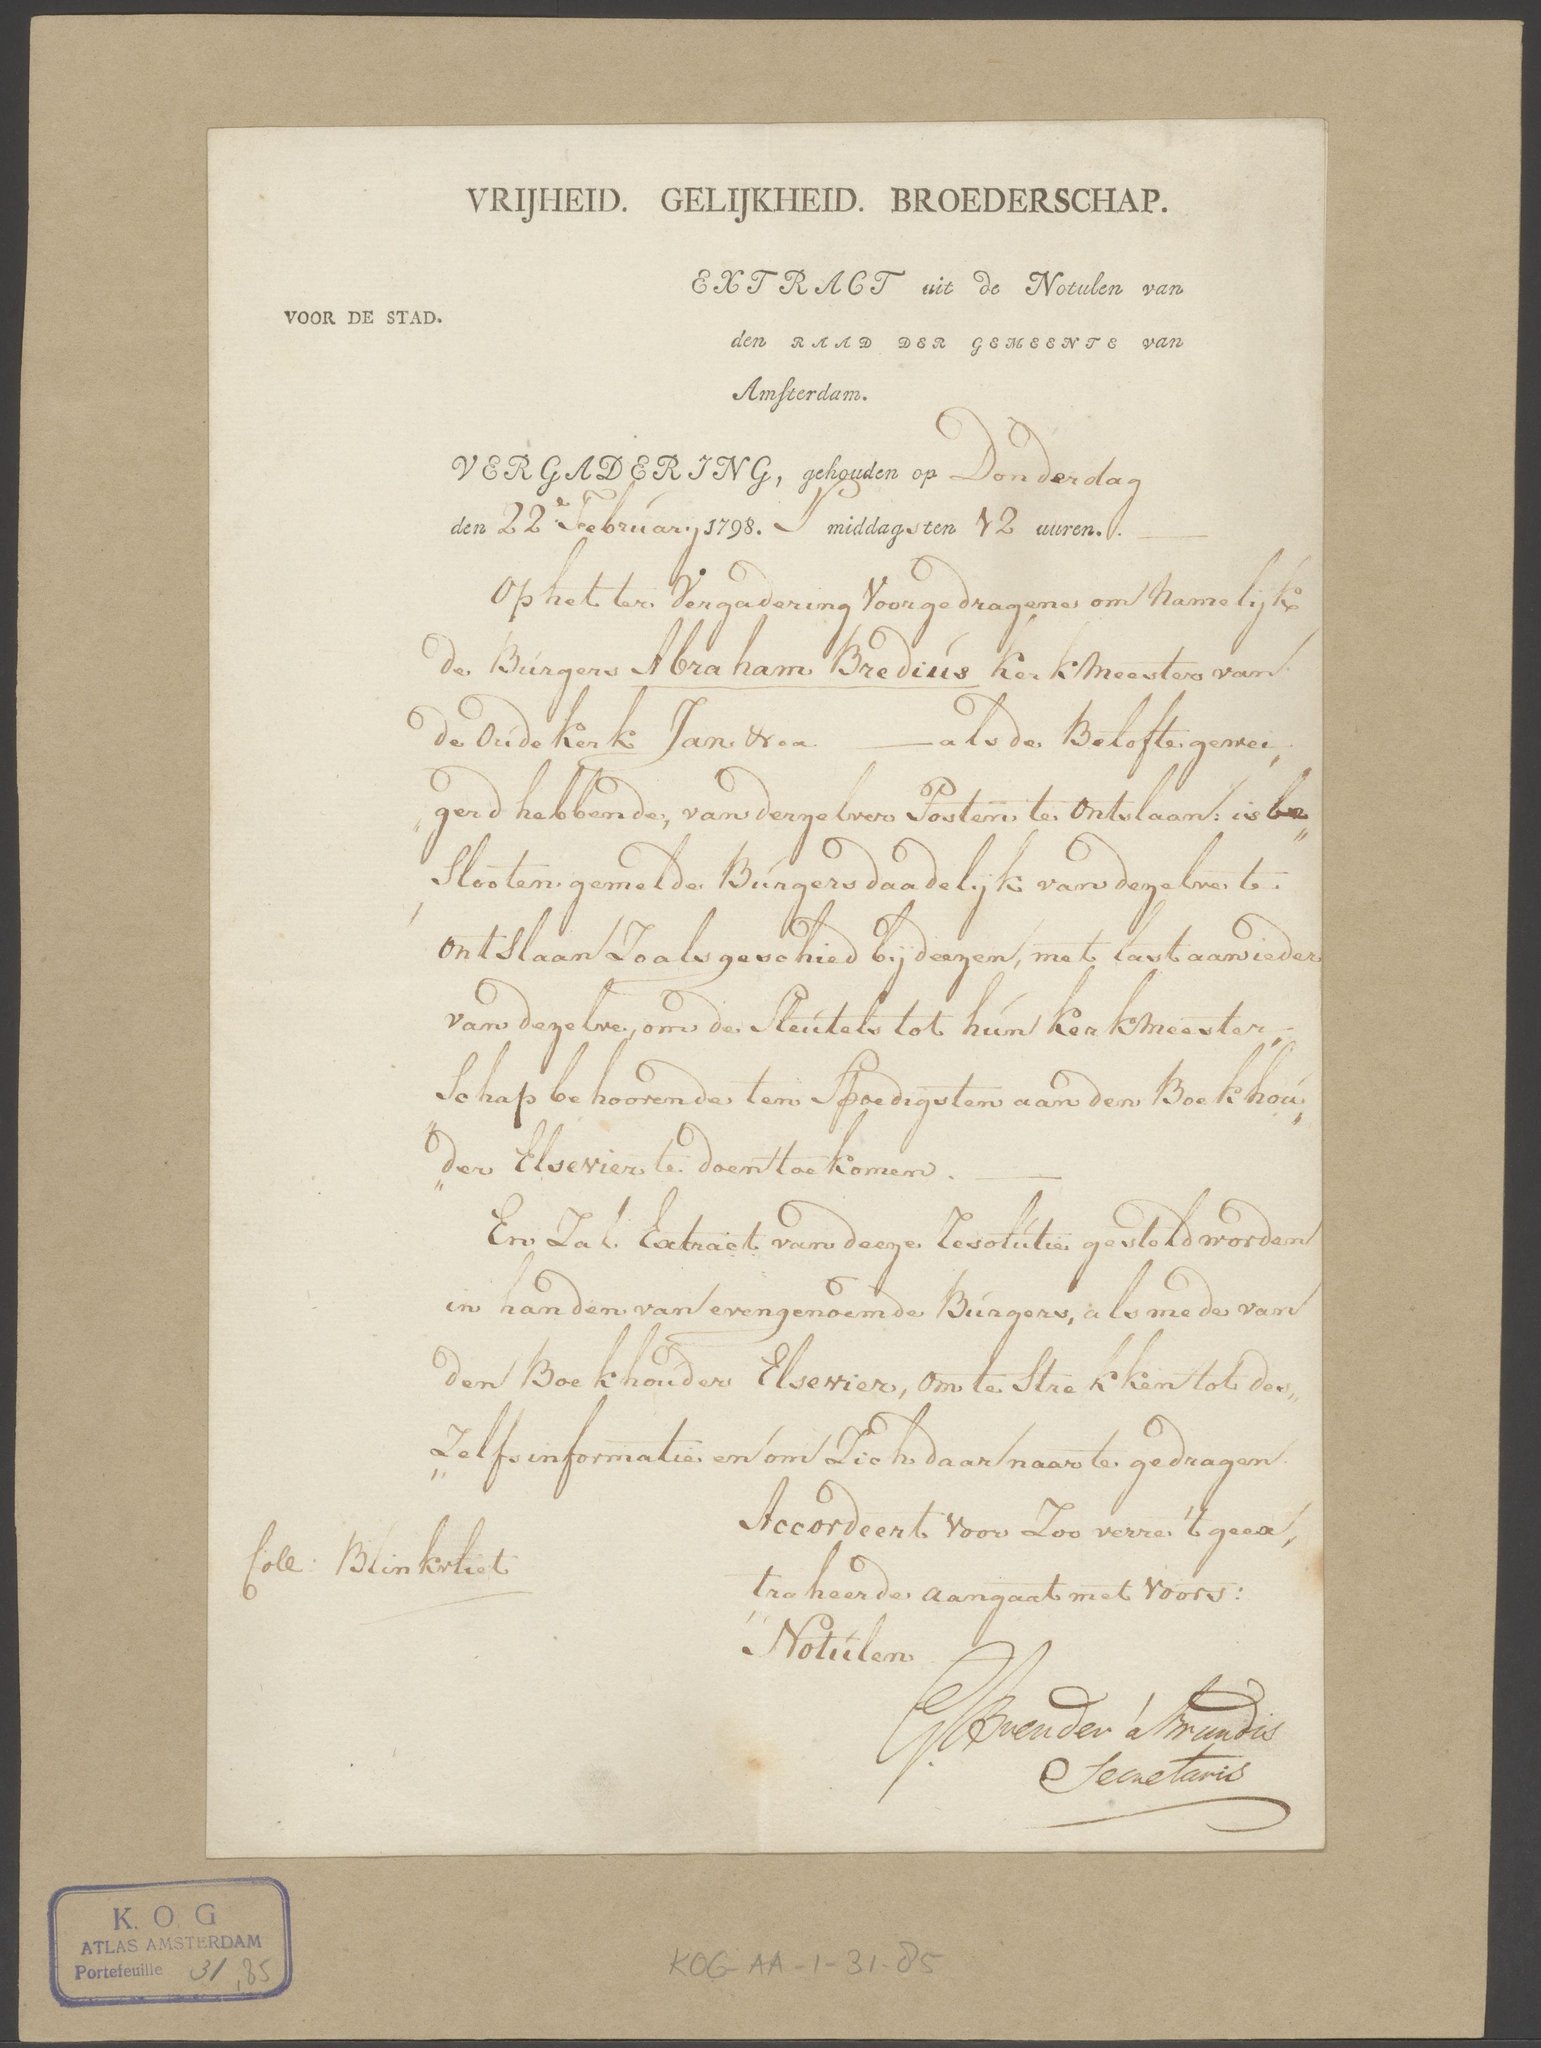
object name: text sheet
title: Vrijheid. Gelijkheid. Broederschap. / Voor de stad. / Extract uit de Notulen van den Raad der Gemeente van Amsterdam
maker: Anonymous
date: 1798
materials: ink, paper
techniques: letterpress printing, pen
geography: amsterdam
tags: oude kerk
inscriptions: collector's mark: ‘31.85’ Lugt 1641b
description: Inzake het ontslag van de Kerkmeester van de Oude Kerk te Amsterdam, Abraham Bredius. Onderwerpsrubriek binnen de Atlas Amsterdam: Kerkwezen: Hervormde Gemeente: Oude Kerk van buiten.